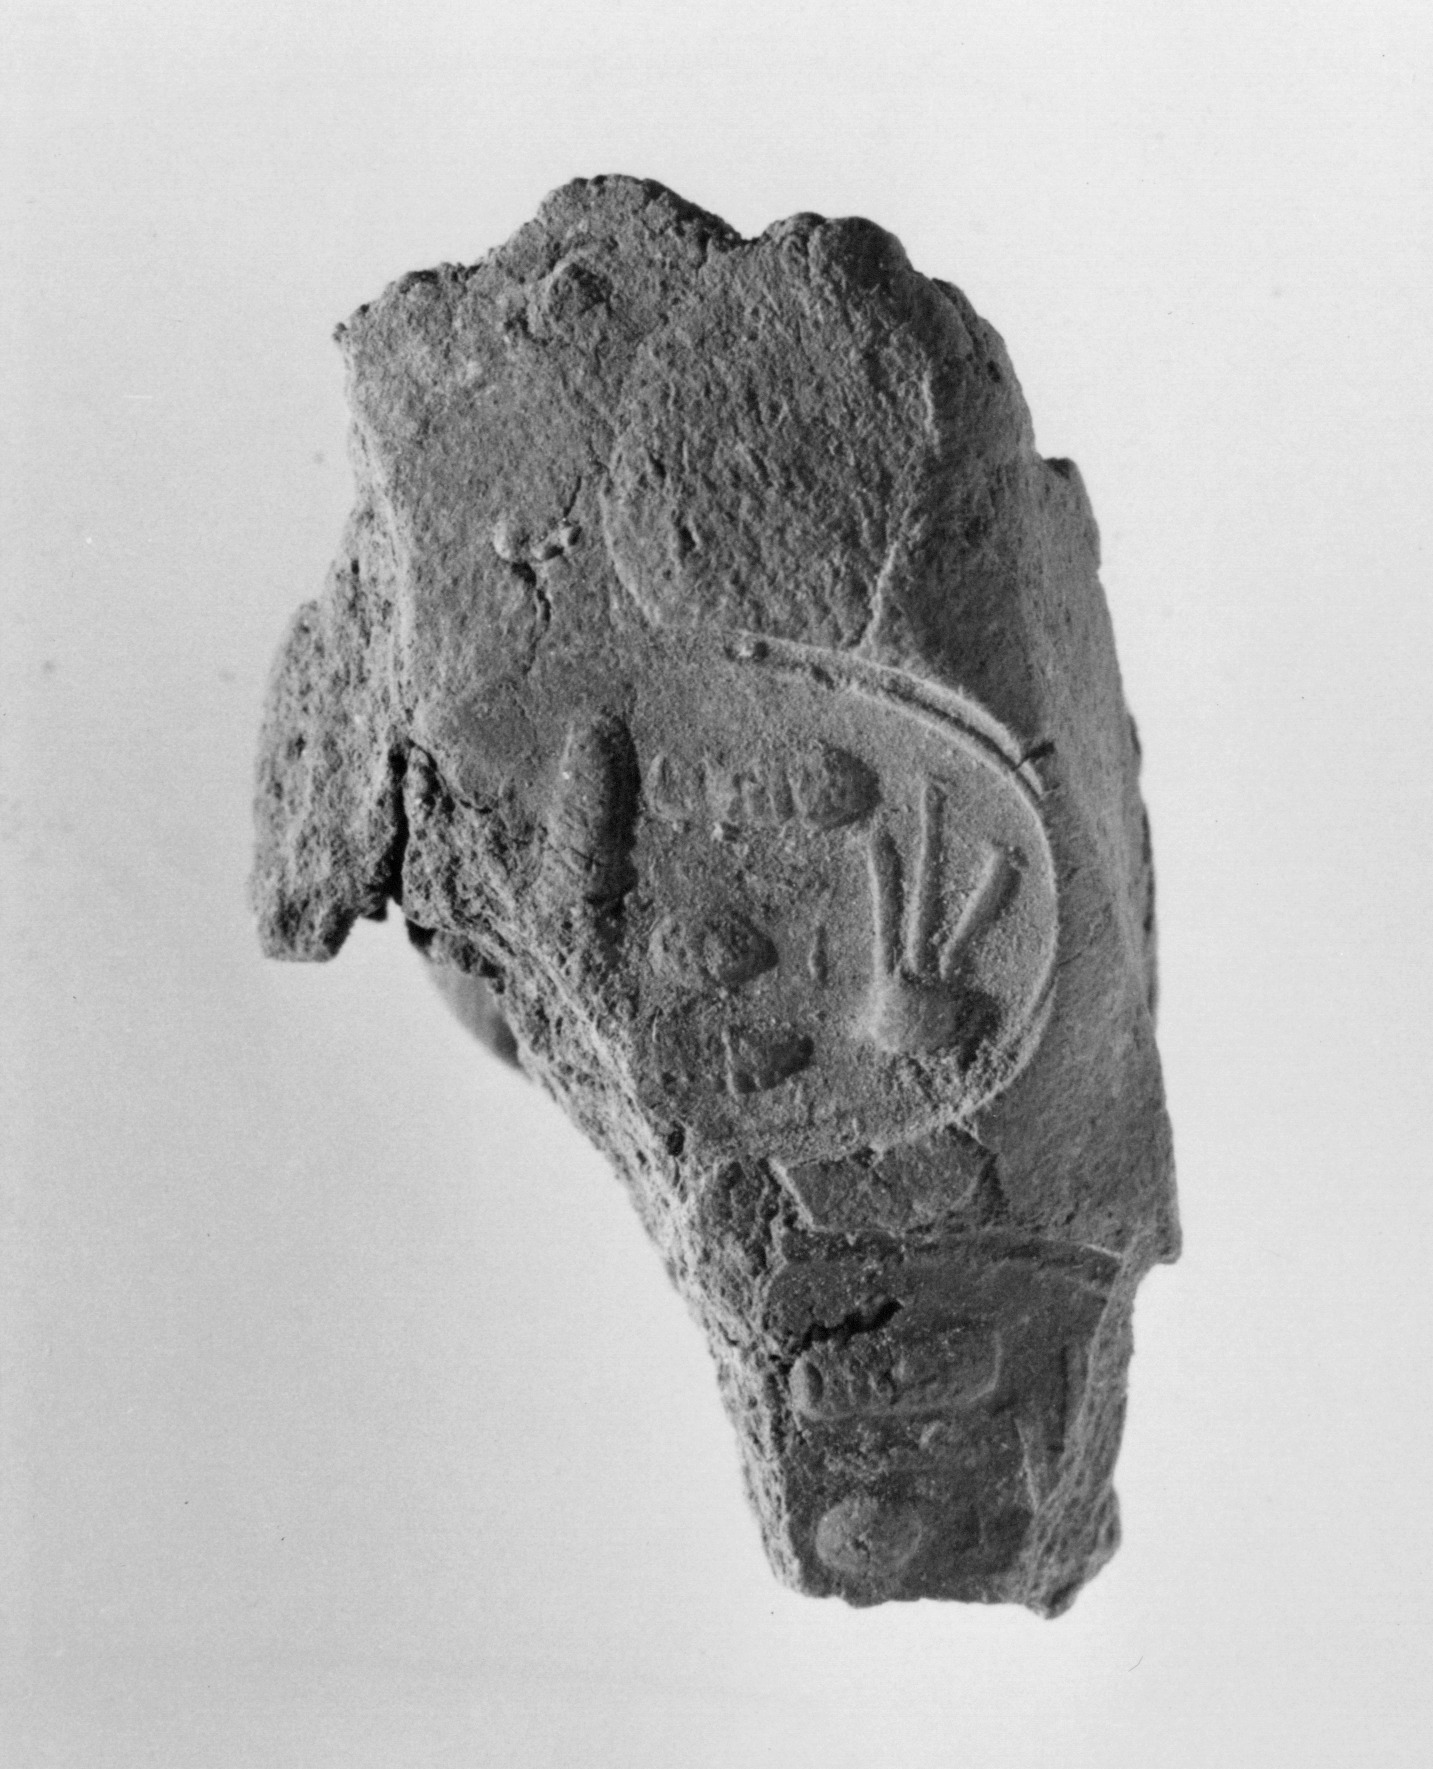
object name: sealing, amun re, upper egypt, lower egypt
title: Document Sealing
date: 1390-1352 BCE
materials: mud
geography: egypt